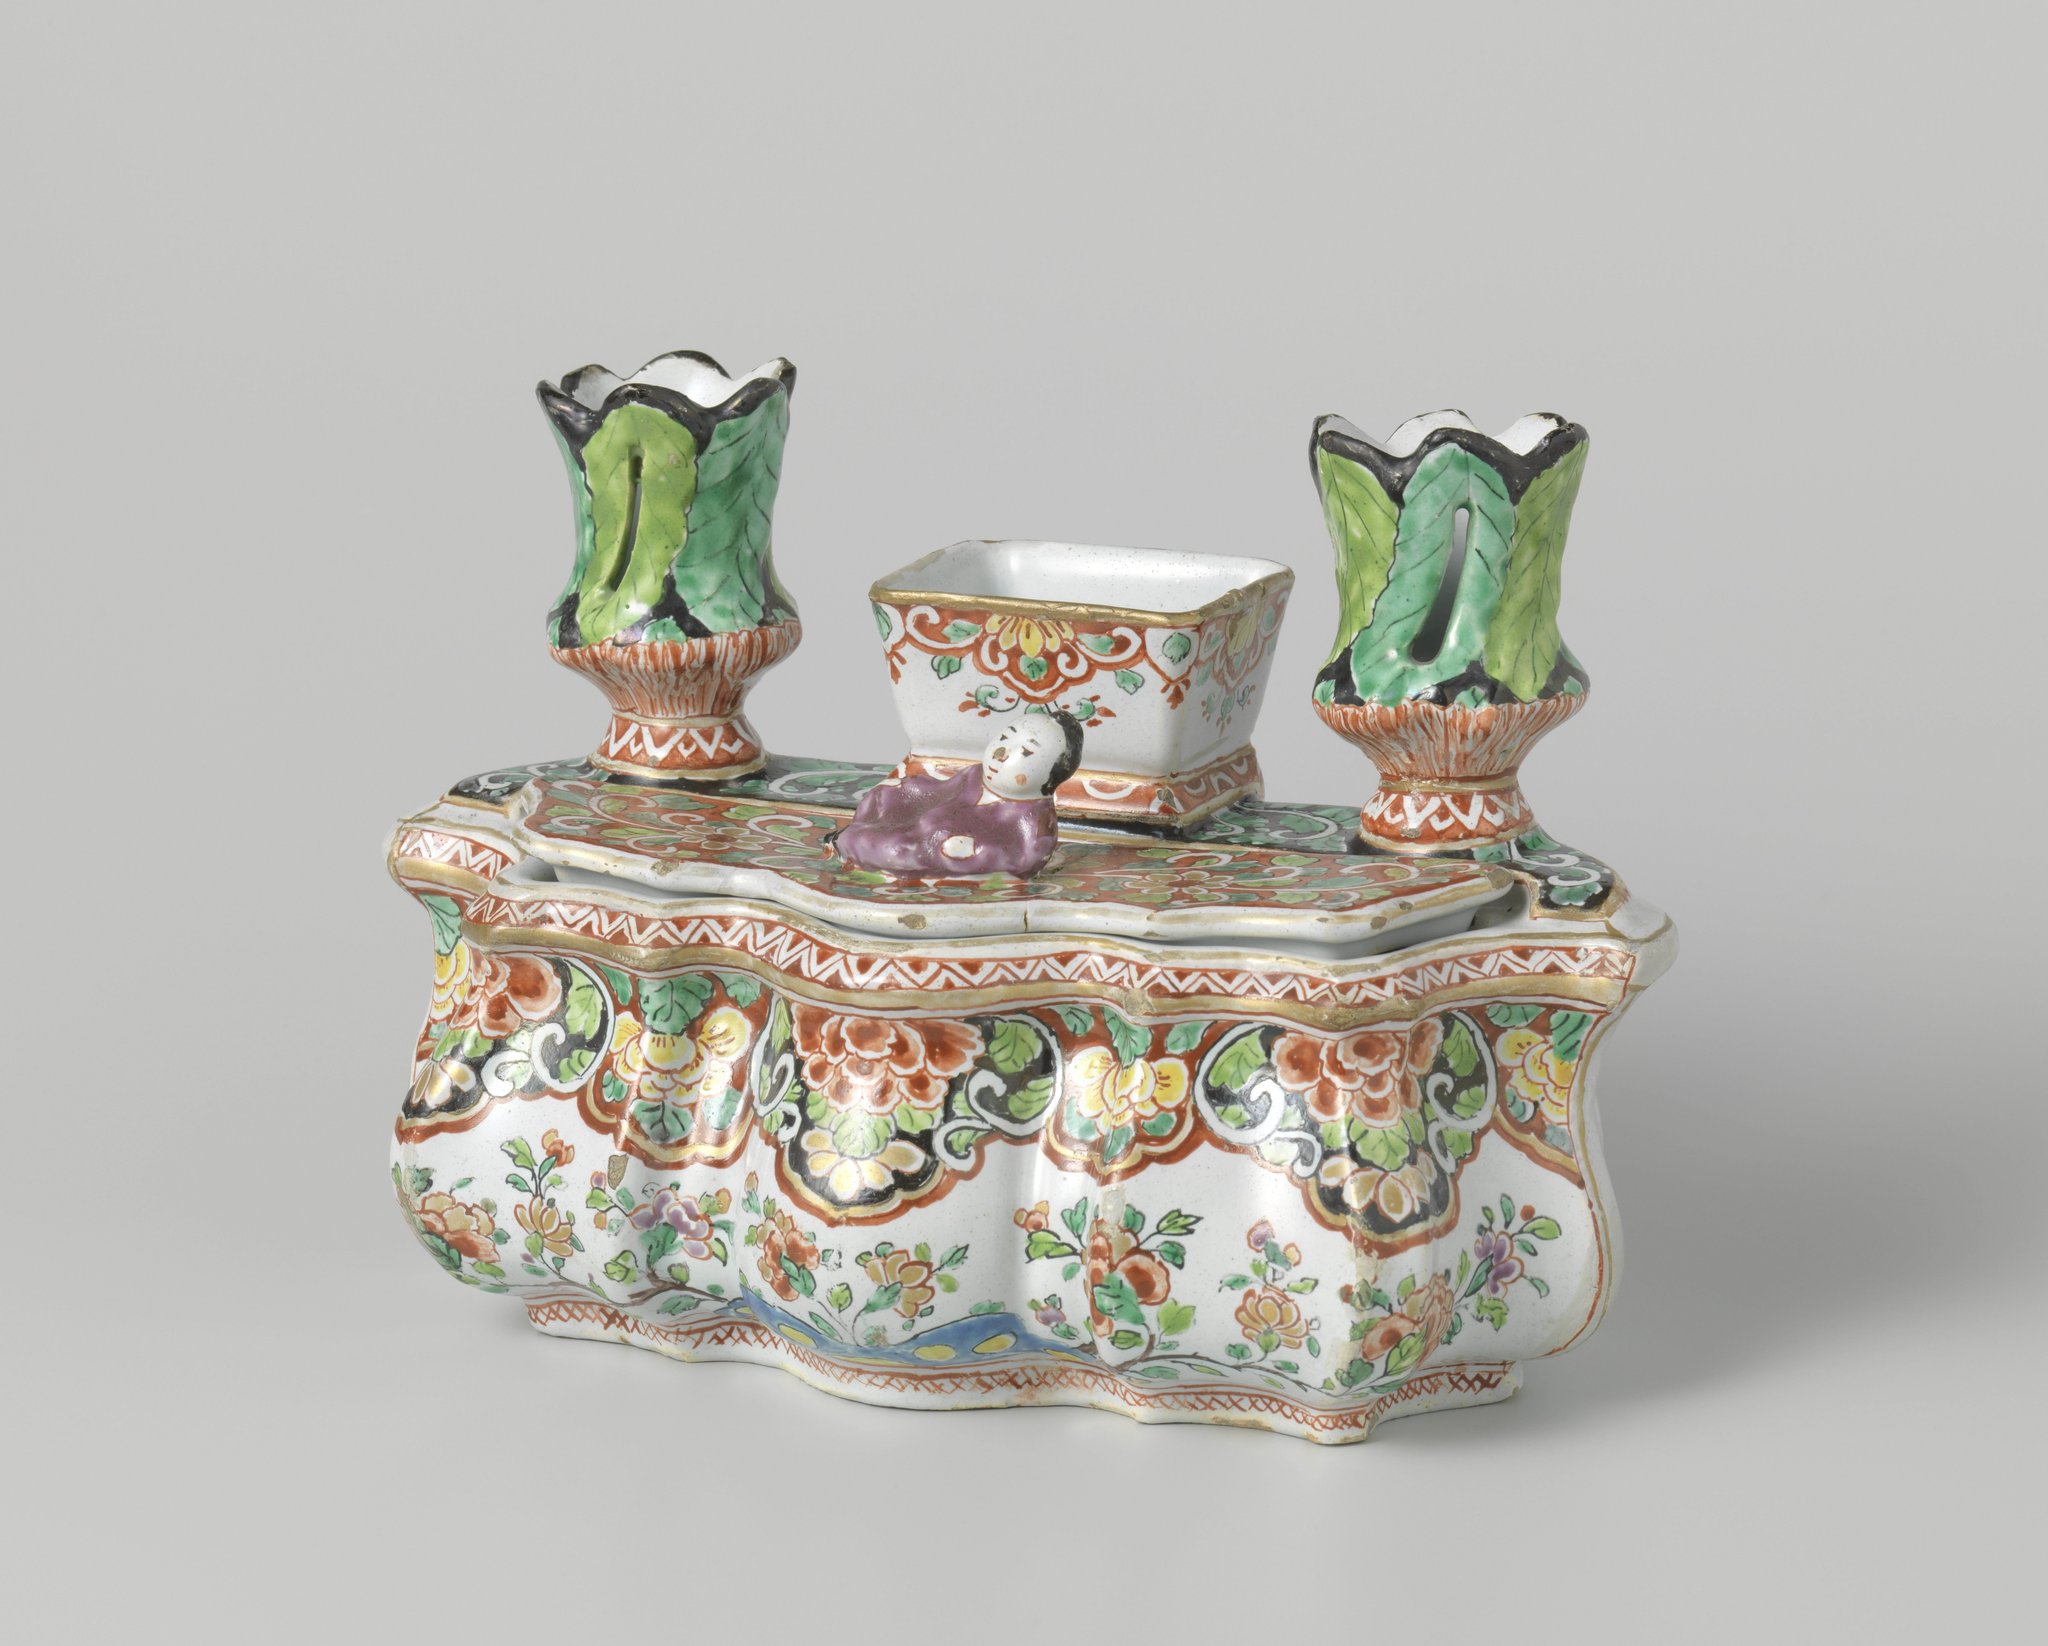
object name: inkstand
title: Inktstel van veelkleurig beschilderde faïence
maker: Anonymous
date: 1750-1775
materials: faience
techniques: kiln, painted, polychromy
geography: delft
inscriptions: collector's mark: ‘collection J.F. Loudon’